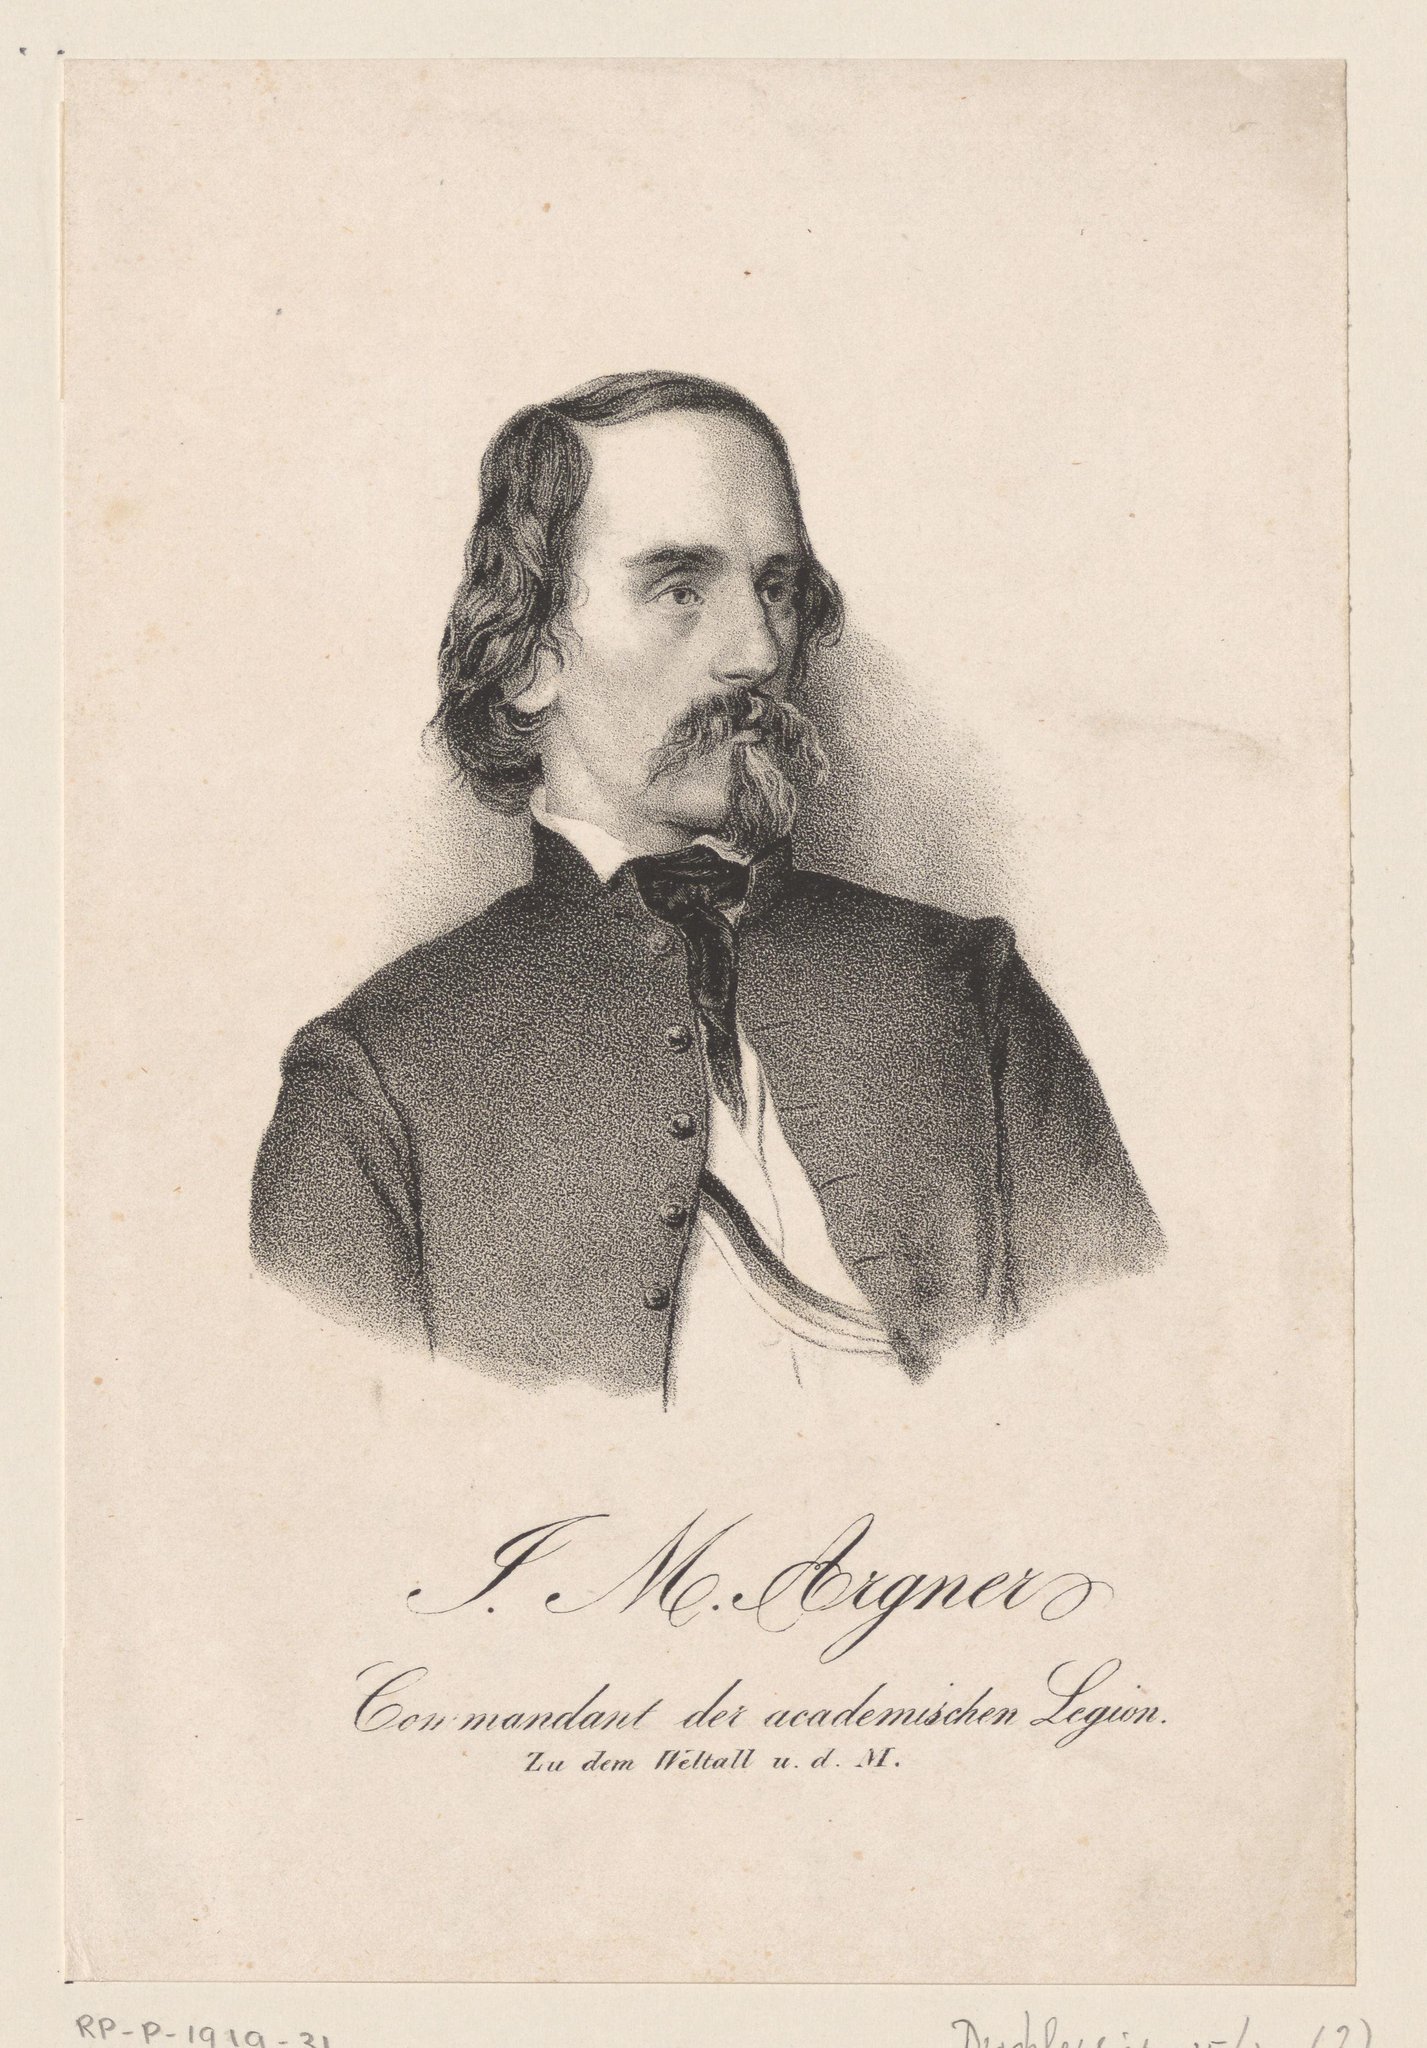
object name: print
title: Portret van Joseph Mattäus Aigner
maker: Anonymous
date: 1840-1860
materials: paper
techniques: lithograph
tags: vienna, painter, historical persons, portrait, self-portrait of painter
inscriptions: collector's mark: Lugt 2228